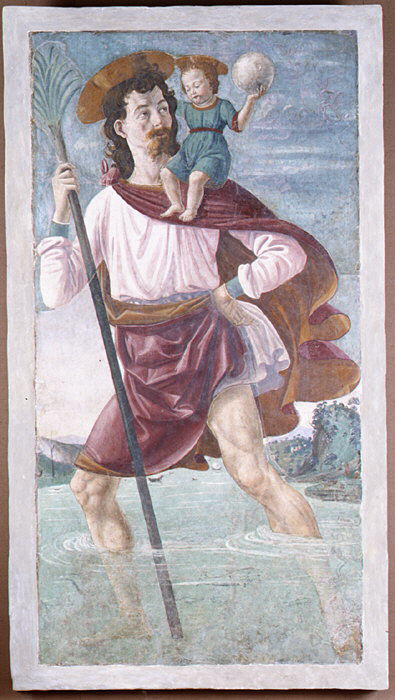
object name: painting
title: Saint Christopher and the Infant Christ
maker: domenico ghirlandaio (domenico bigordi)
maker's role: artist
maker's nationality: italian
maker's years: 1448-1494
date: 1469-1494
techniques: fresco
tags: rivers,saint christopher,jesus